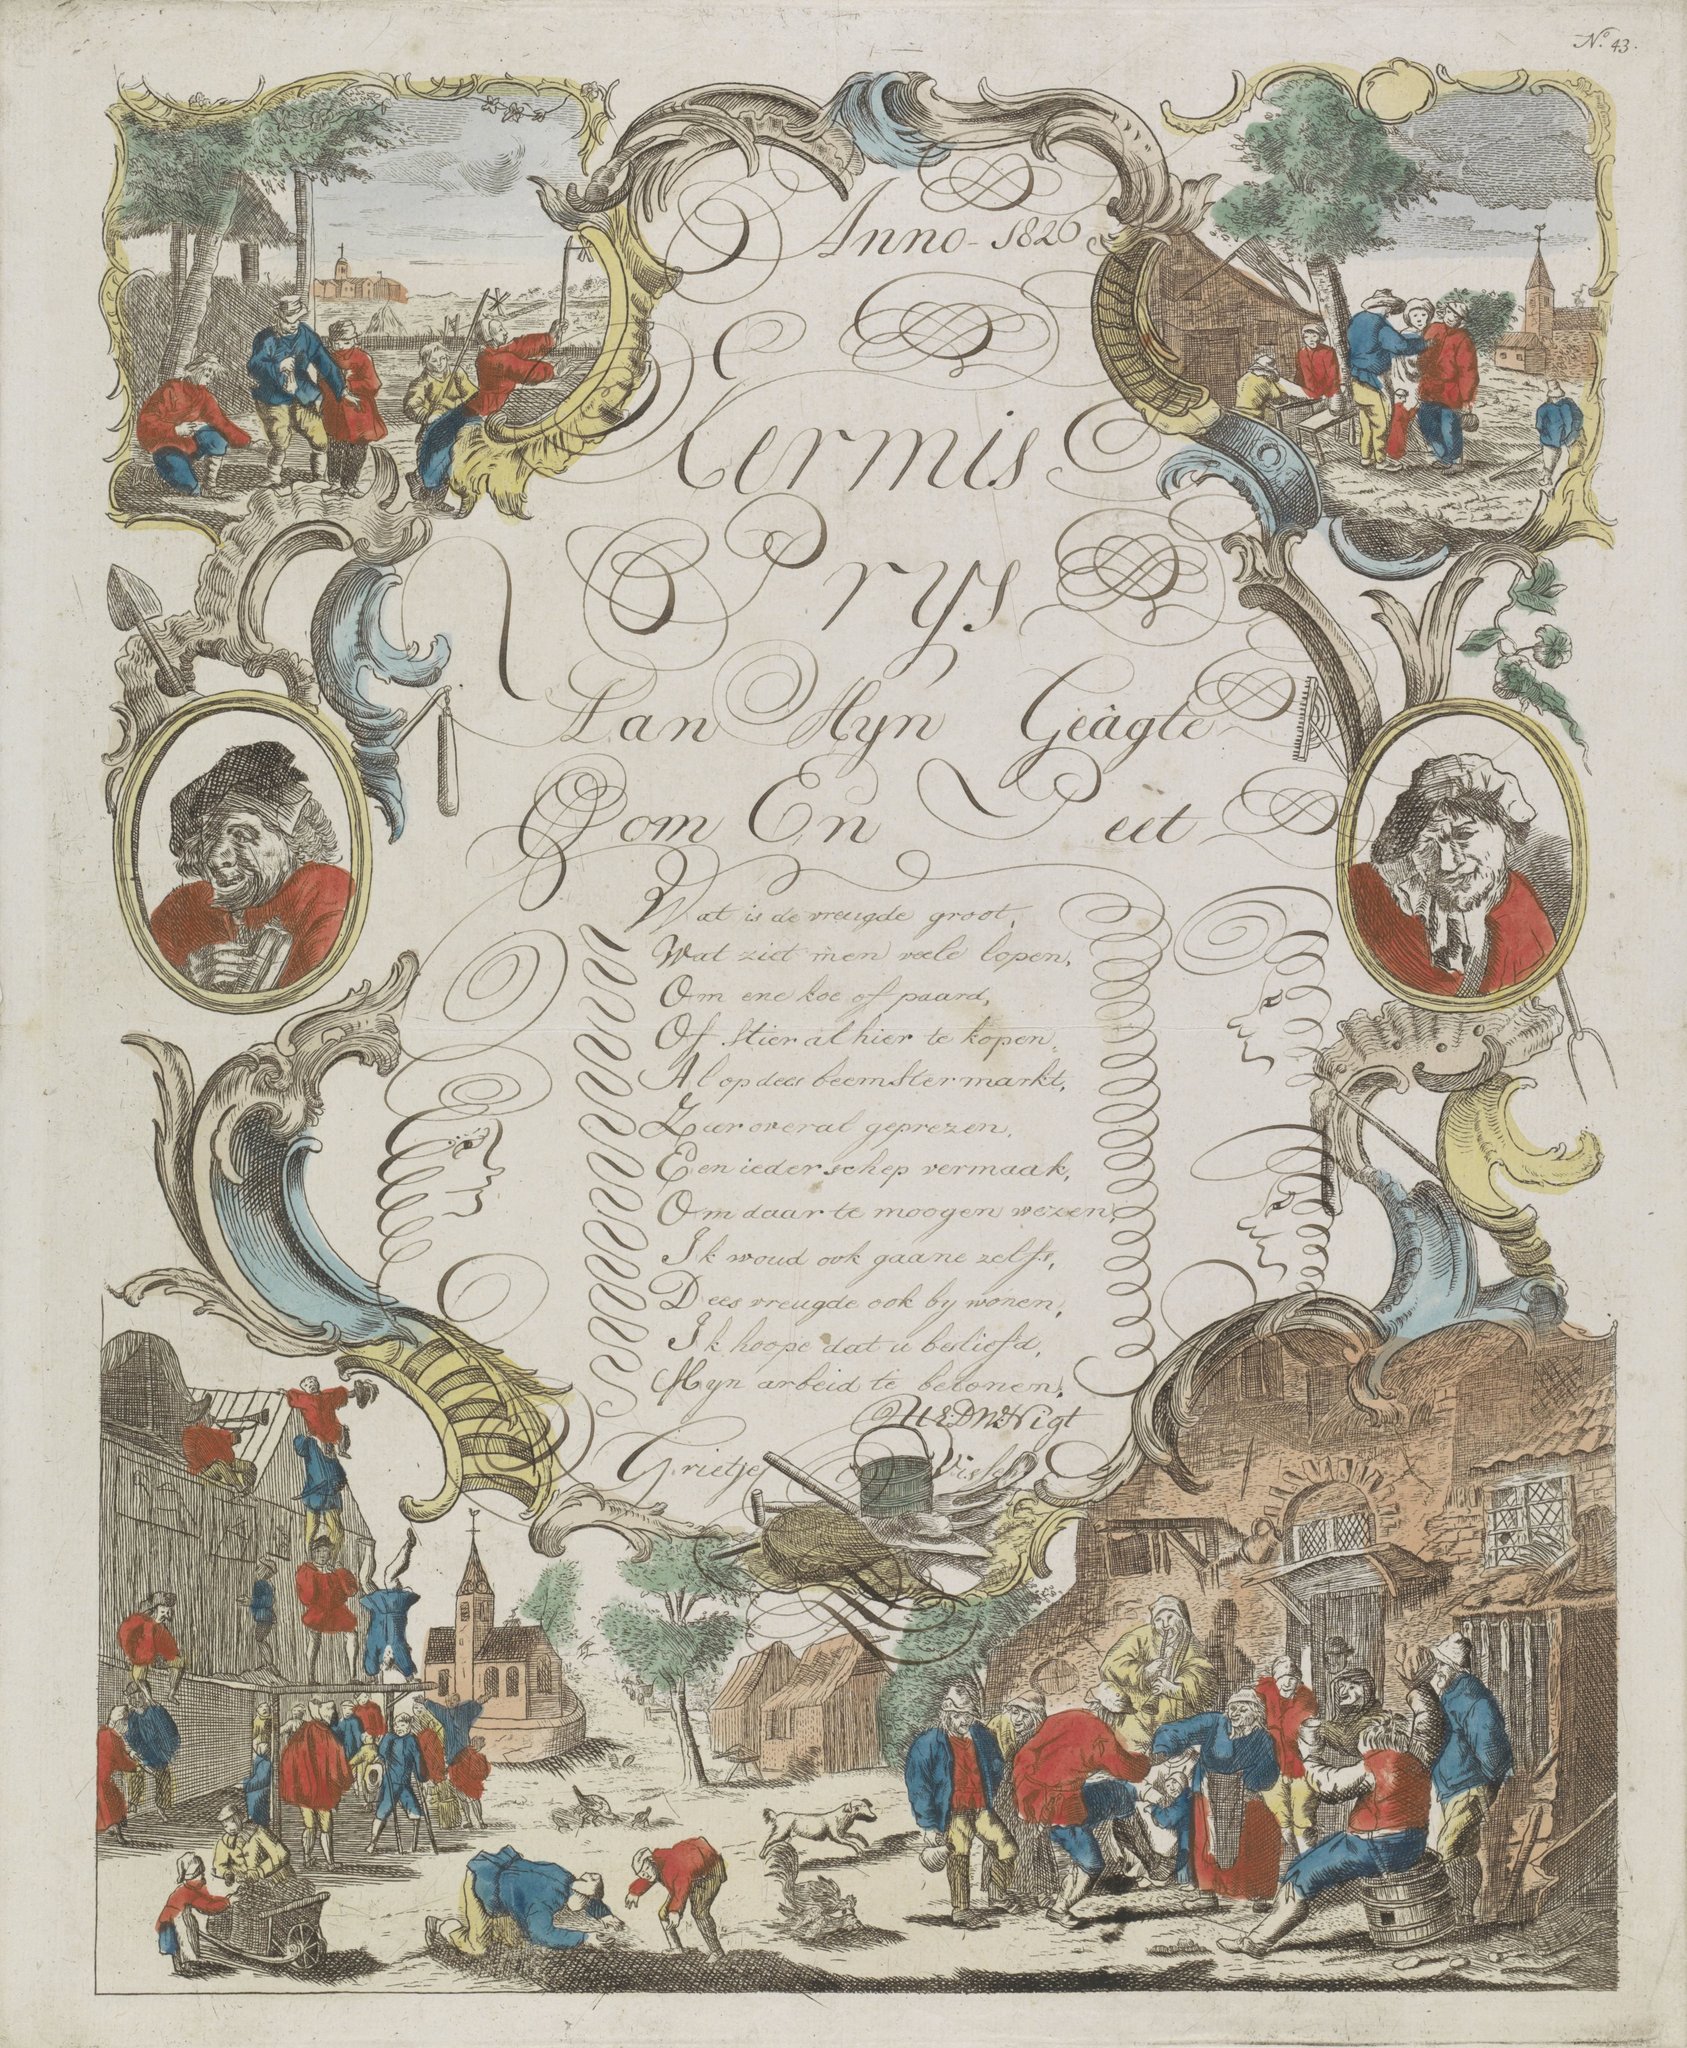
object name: print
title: Wensbrief met een herberg, drinkende boeren en acrobaten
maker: Anonymous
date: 1826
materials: ink, paper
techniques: calligraphy, colour, etching, pen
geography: netherlands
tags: farmers, acrobat ~ circus, the show; fair and circus performers, alcoholic drinks, drinking, hotel, hostelry, inn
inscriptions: inscription: ‘Kermis prijs / Aan mijn geàgte / Oom en peet / Wat is de vreugde groot ...’, collector's mark: Lugt 2760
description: Wensbrief met beschreven cartouche binnen een decoratief kader met voorstellingen van een herberg, drinkende boeren en acrobaten. Handgeschreven bericht in kalligrafie (kermisprijs) door Grietje Visscher aan haar oom en peet. Genummerd rechtsboven: No. 43.